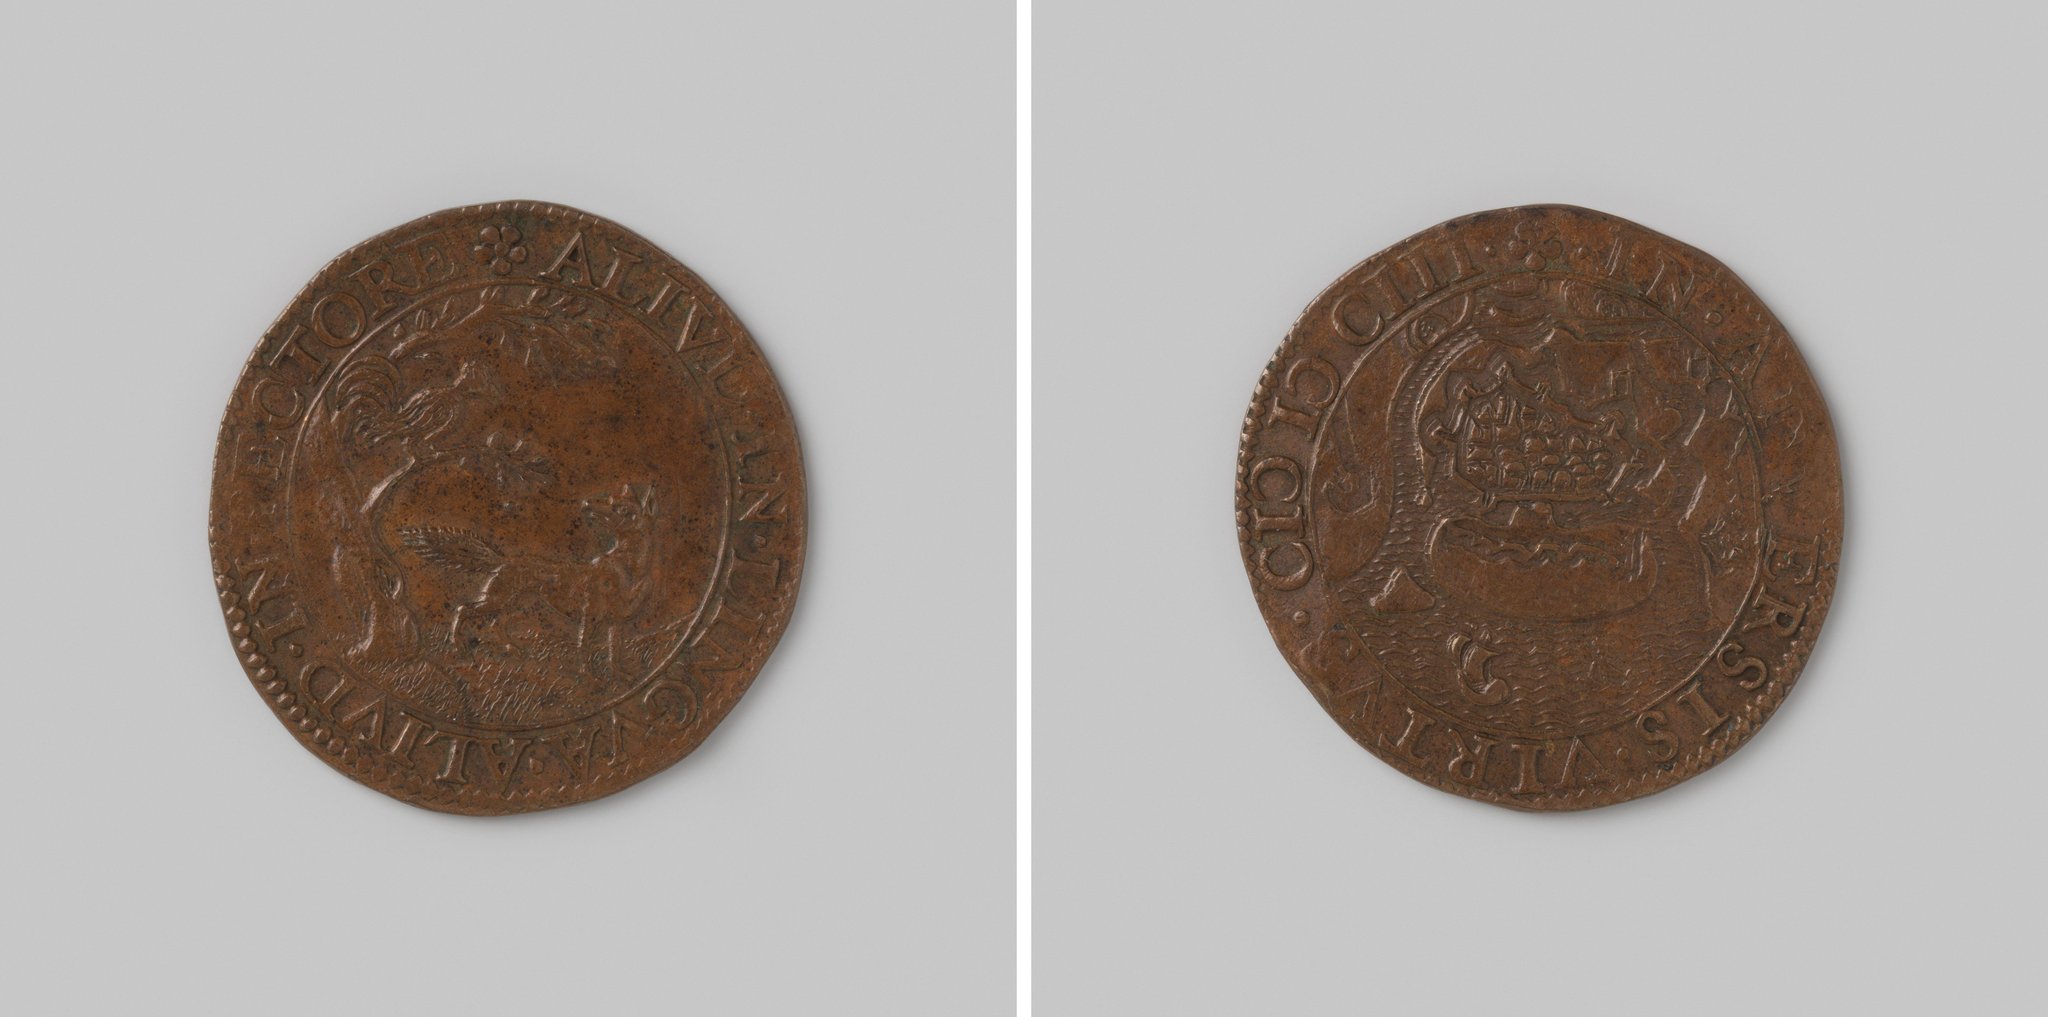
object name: jeton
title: Rekenpenning uit Dordrecht op de geveinsde vergiffenis van Aartshertog Albertus 1603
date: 1603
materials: copper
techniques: striking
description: Koperen penning, op de voorzijde een raaf in een boom waaronder een vos, met omschrift, op de keerzijde de plattegrond van Ostende met omschrift.